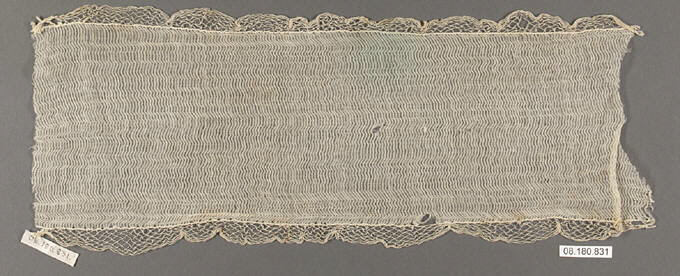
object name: fragment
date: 1701-1800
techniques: embroidery